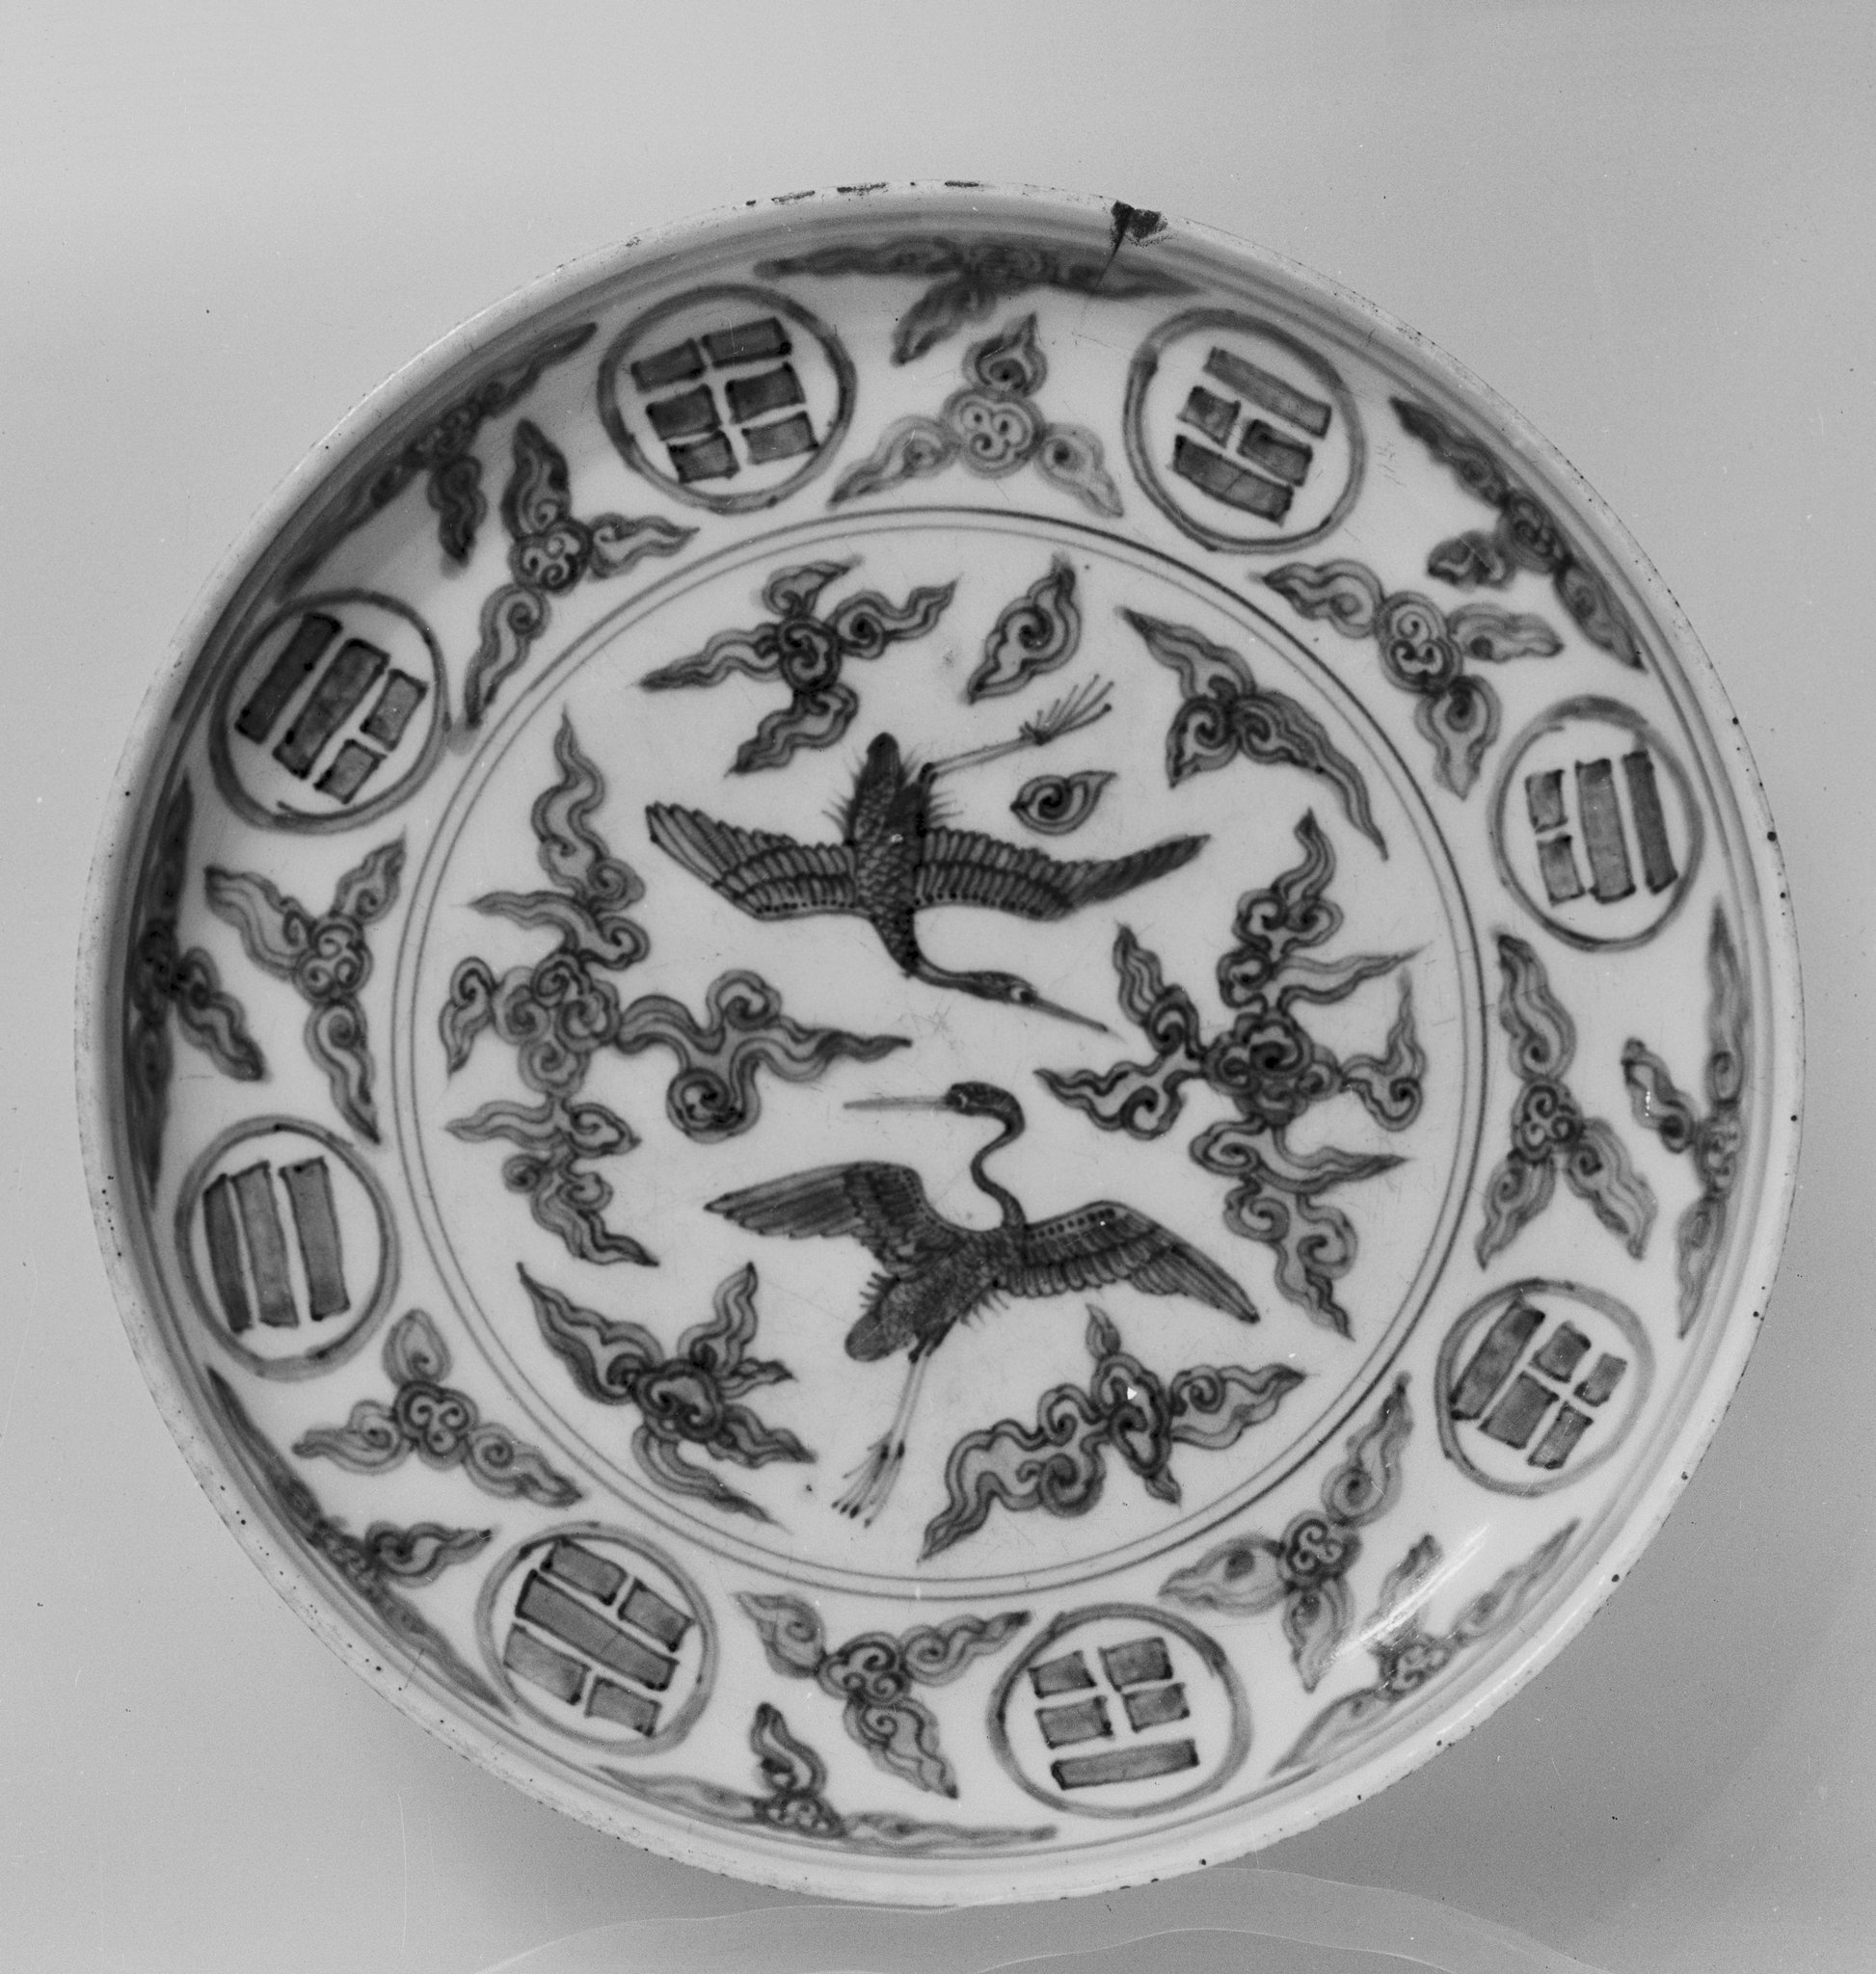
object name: dish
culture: chinese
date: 1522-1566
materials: porcelain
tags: birds